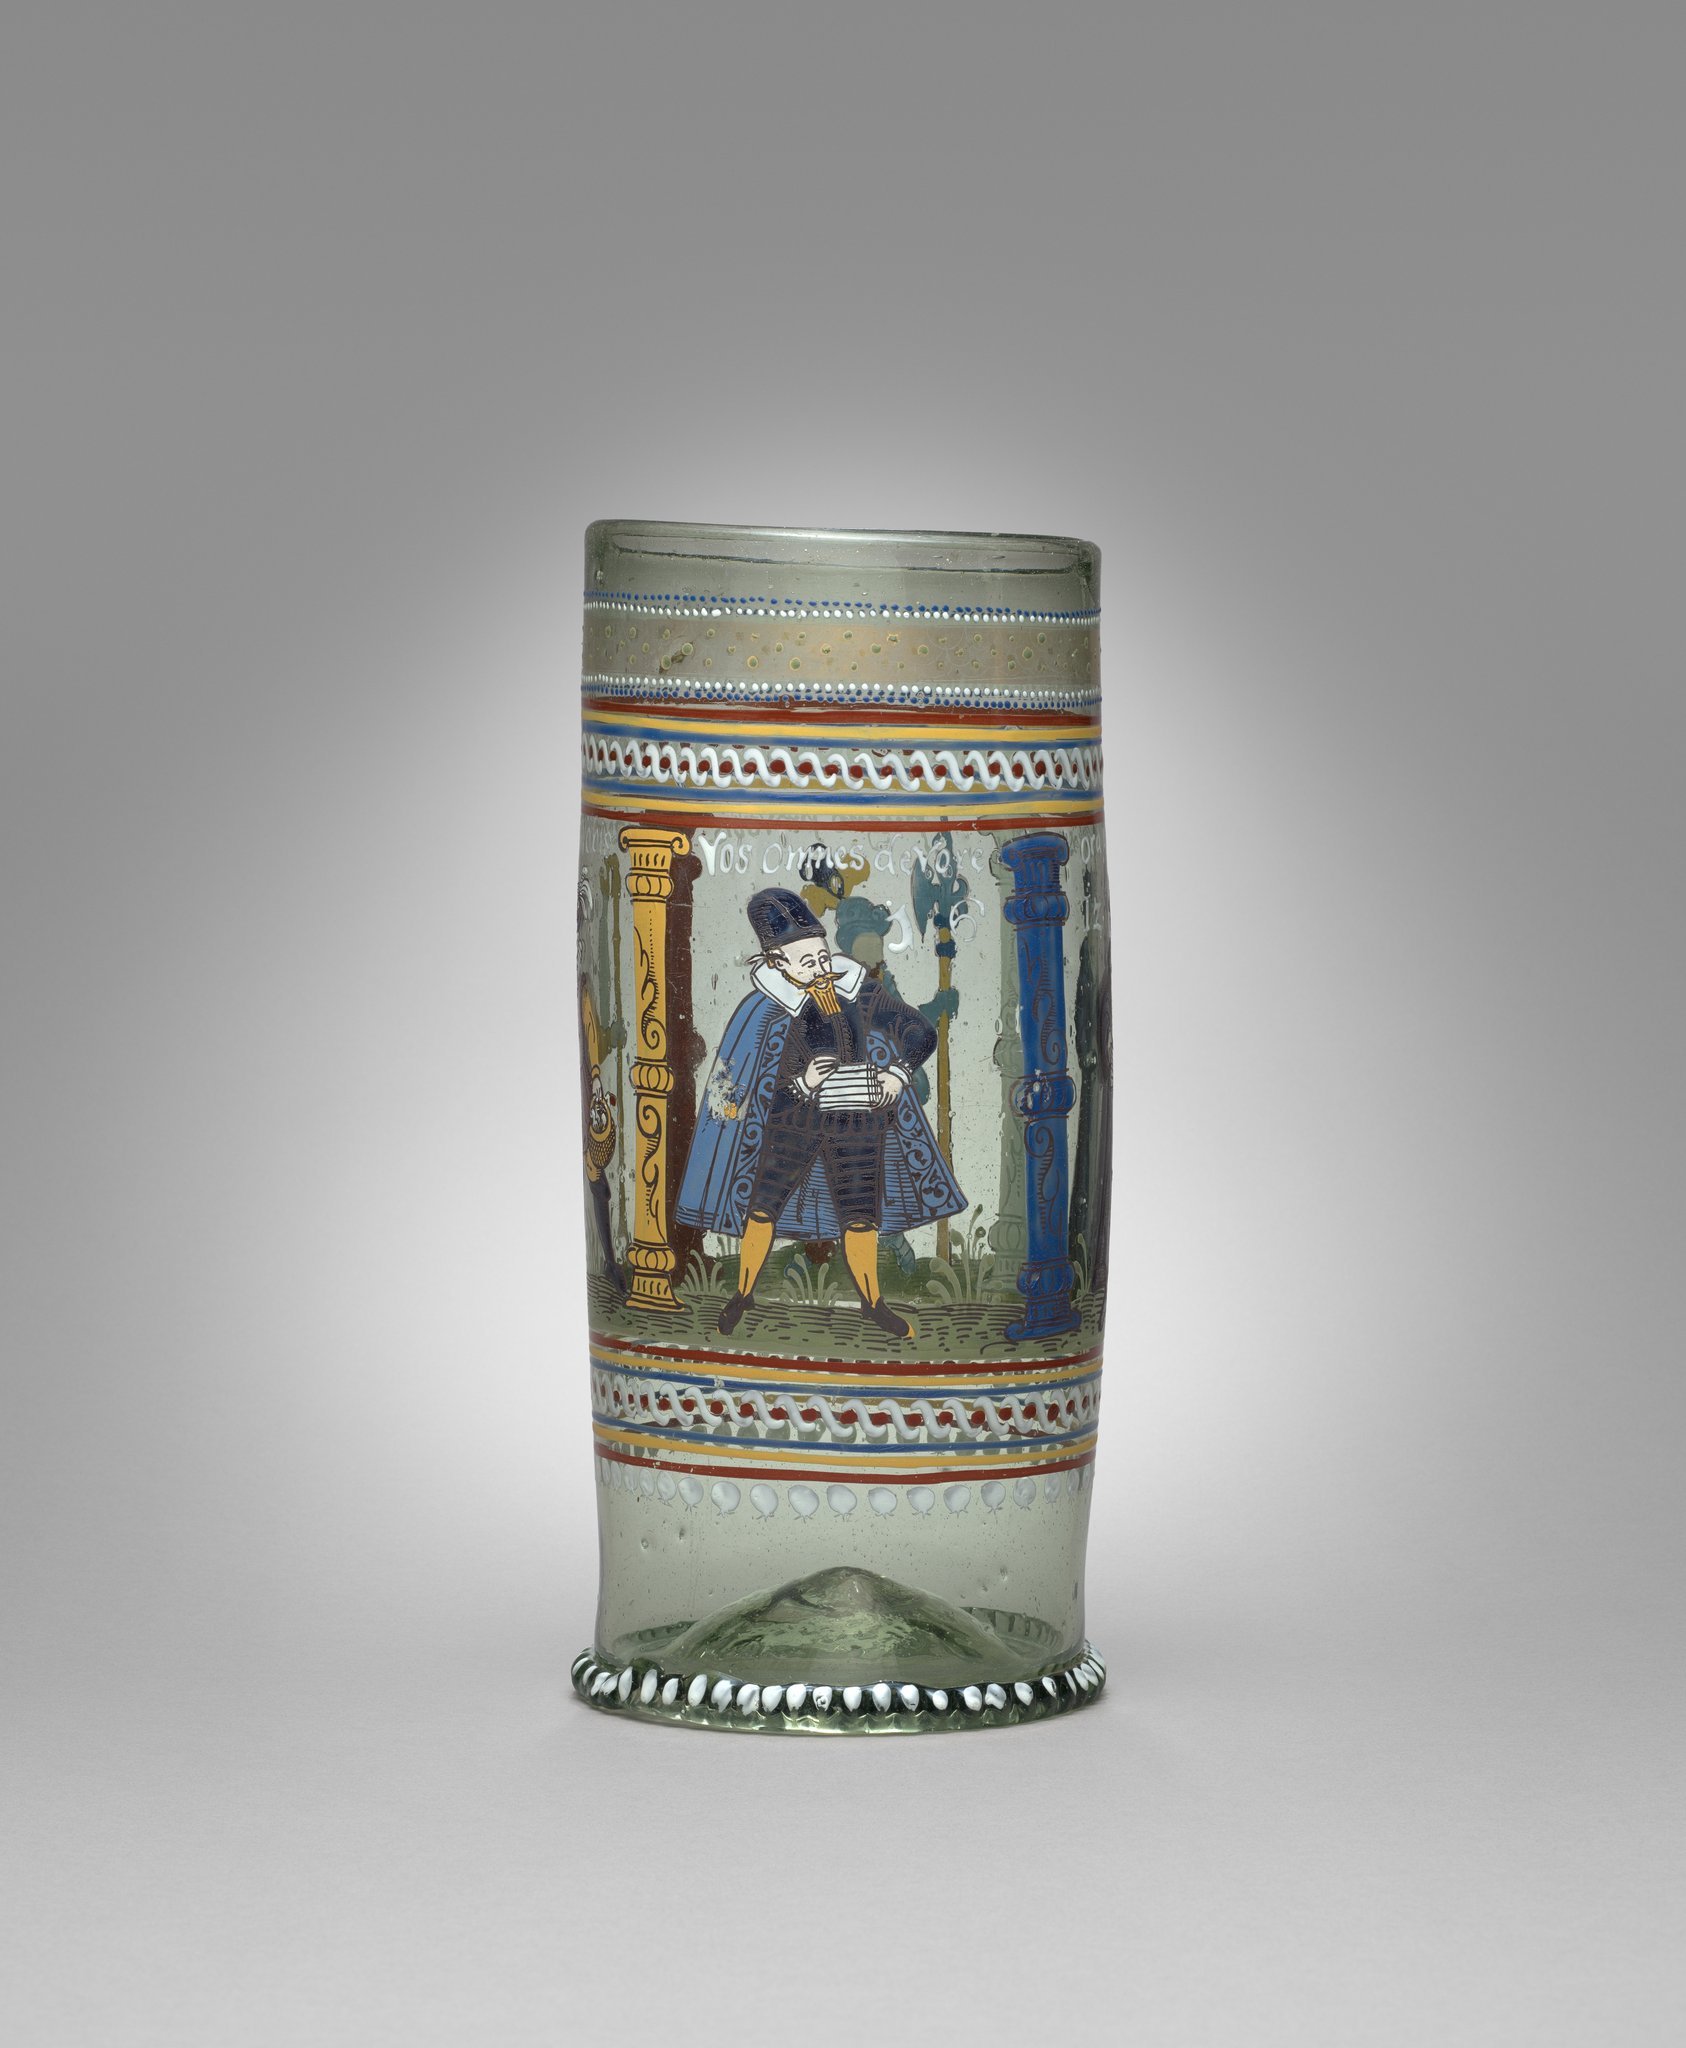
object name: beaker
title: Beaker (Humpen)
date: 1612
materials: glass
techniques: enamel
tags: men